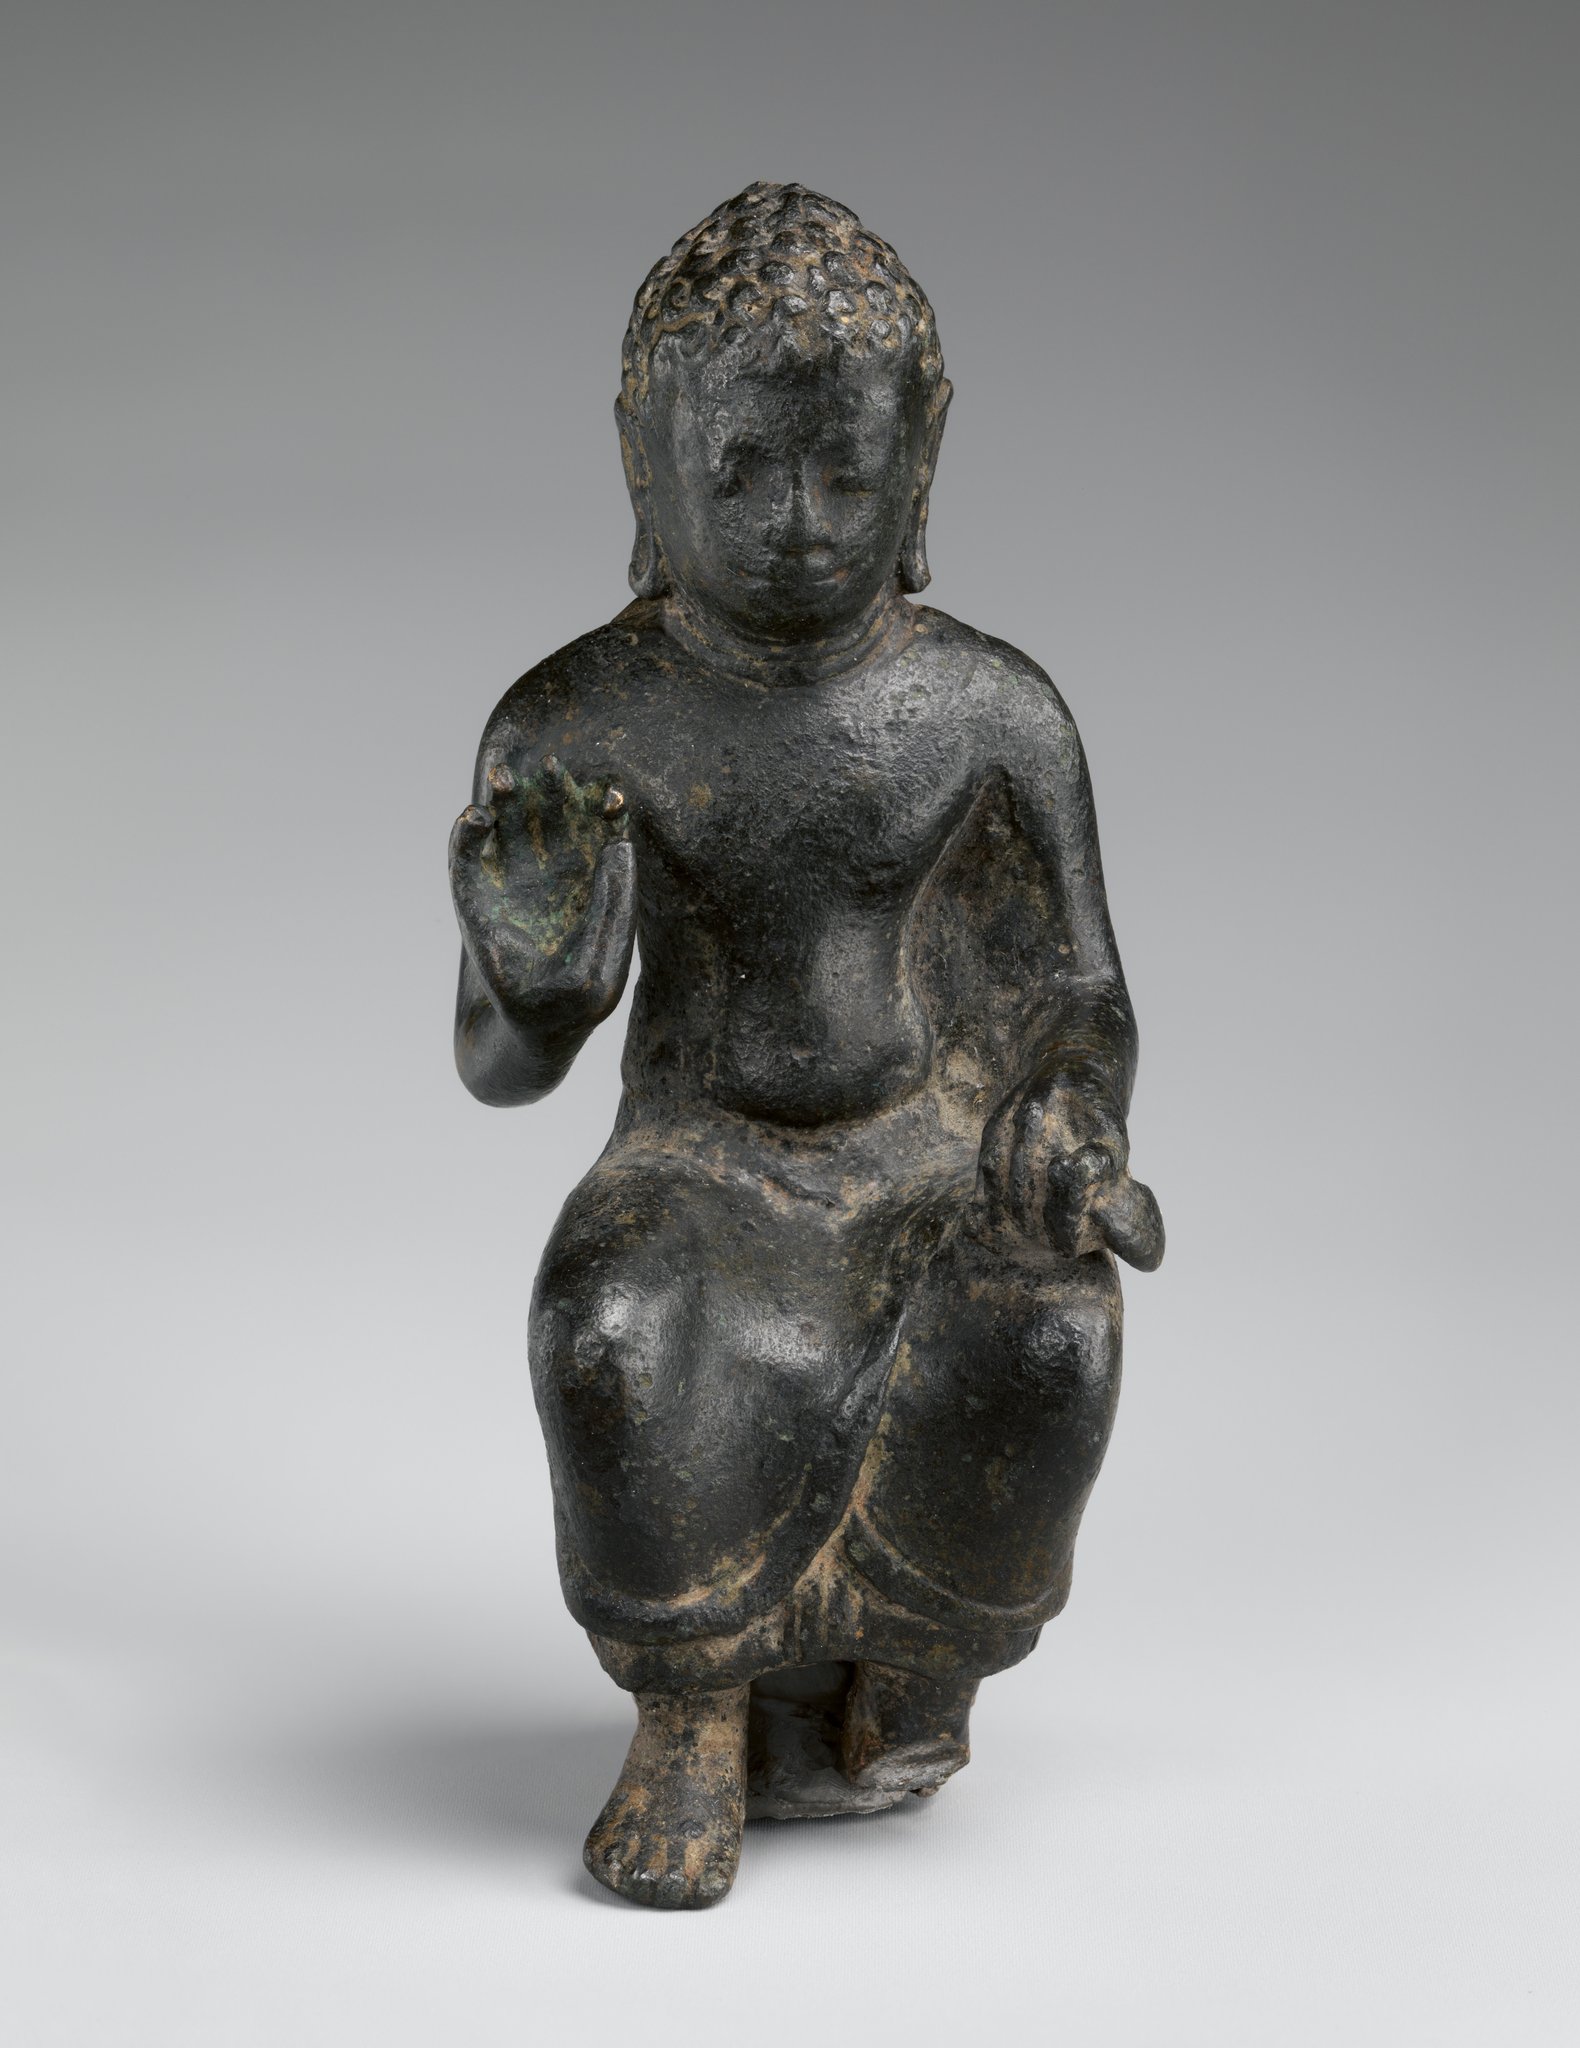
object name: figure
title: Seated Protective Buddha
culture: thai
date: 551-600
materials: copper alloy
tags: buddhism,buddha